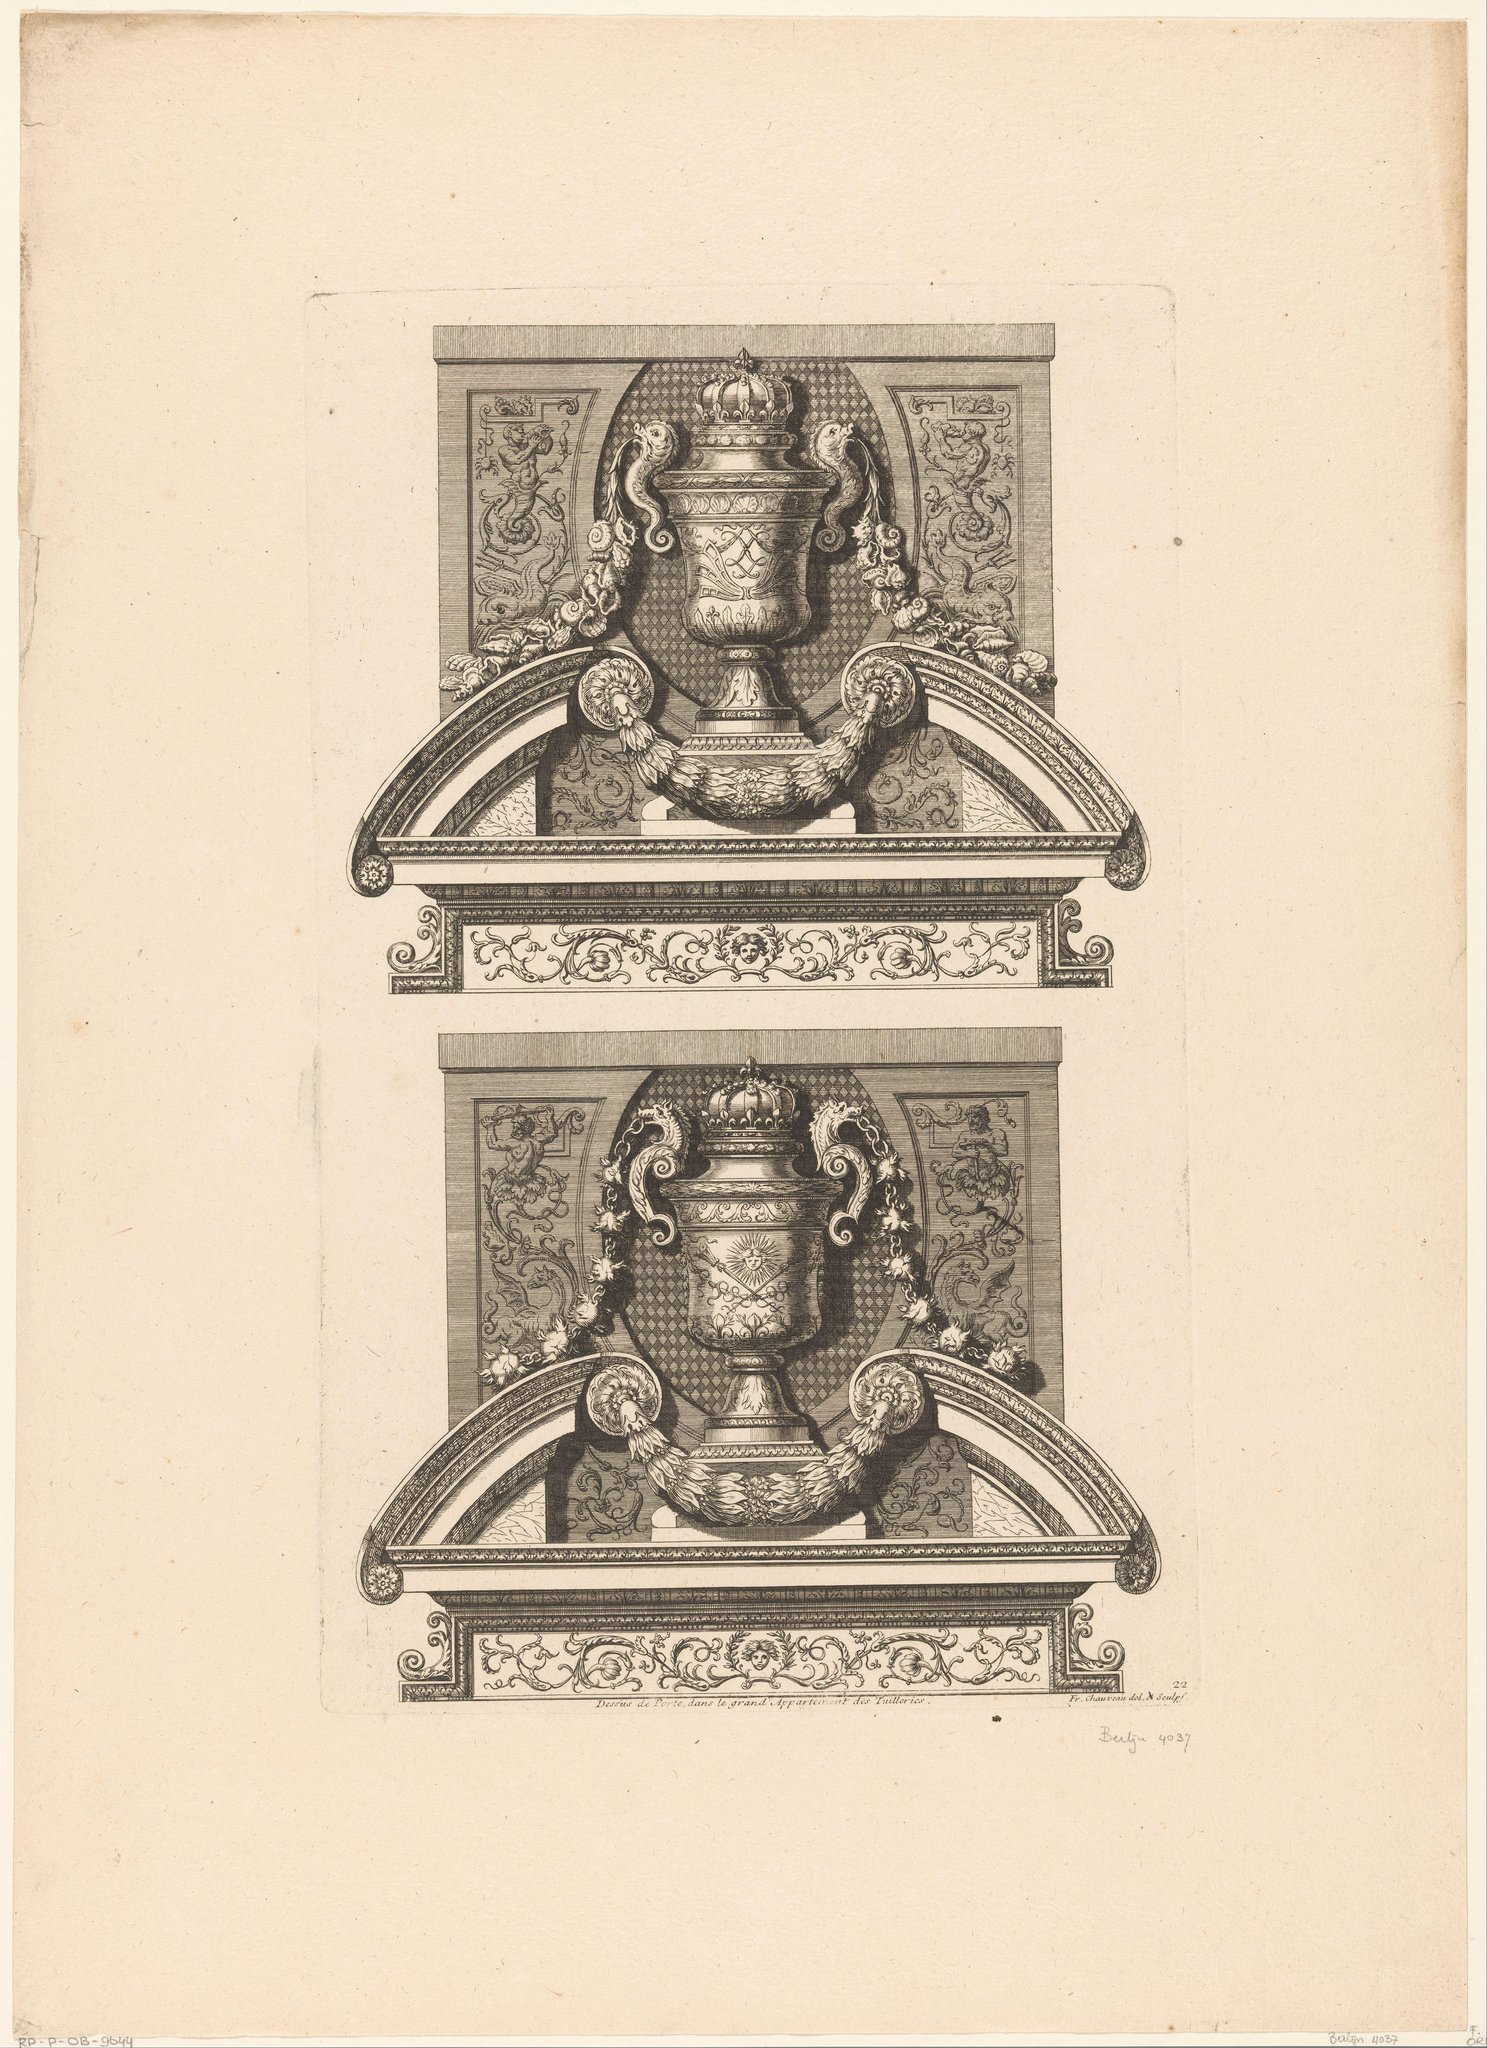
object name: print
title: Dessus-de-portes met vazen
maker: françois chauveau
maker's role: draughtsman, painter, print maker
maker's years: 1613-1676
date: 1670-1676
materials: paper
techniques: etching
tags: vase ~ ornament, door, tuileries palace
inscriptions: collector's mark: Lugt 2228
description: Elf prenten van Jean Bérain le Vieux (RP-P-OB-9624 t/m 9634), dertien prenten van François Chauveau (RP-P-OB-9635 t/m 9647), vier prenten van Lemoine (RP-P-OB-9674 t/m 9677) en een titelprent (in 1710 toegevoegd) vormen tezamen een serie van 29.